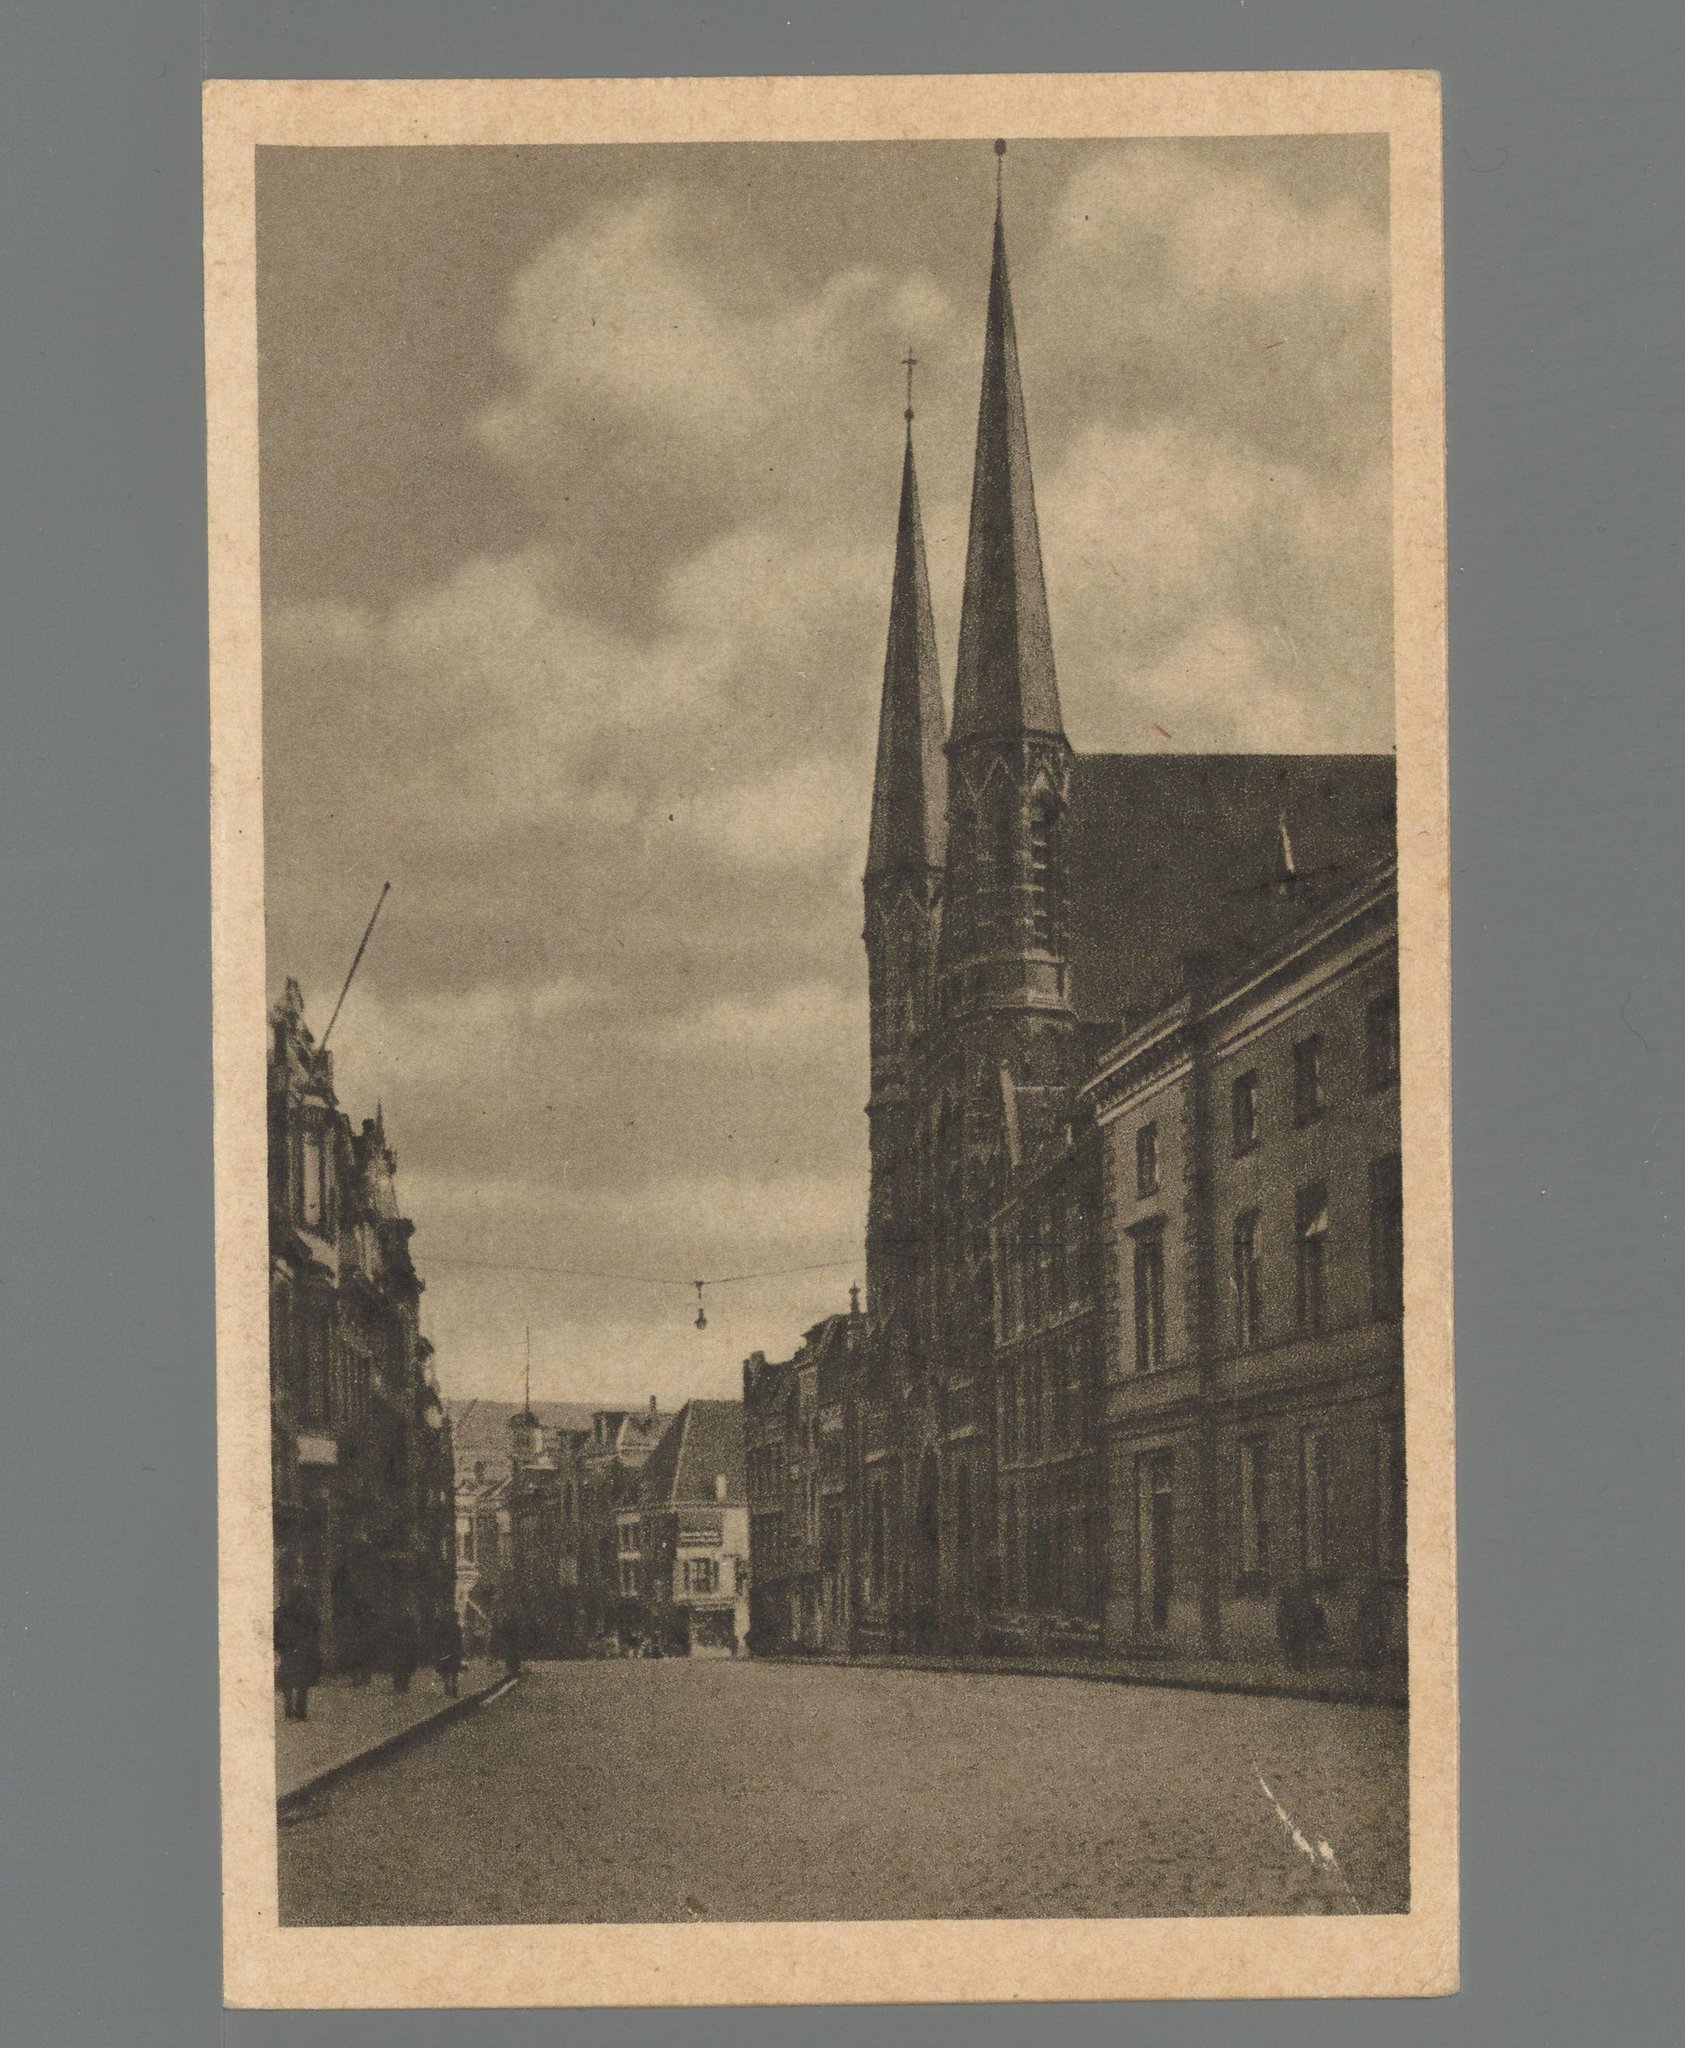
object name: photomechanical print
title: Nijmegen, Molenstraat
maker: Anonymous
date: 1913-1930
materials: cardboard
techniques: rotogravure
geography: nijmegen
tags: church (exterior), street, nijmegen